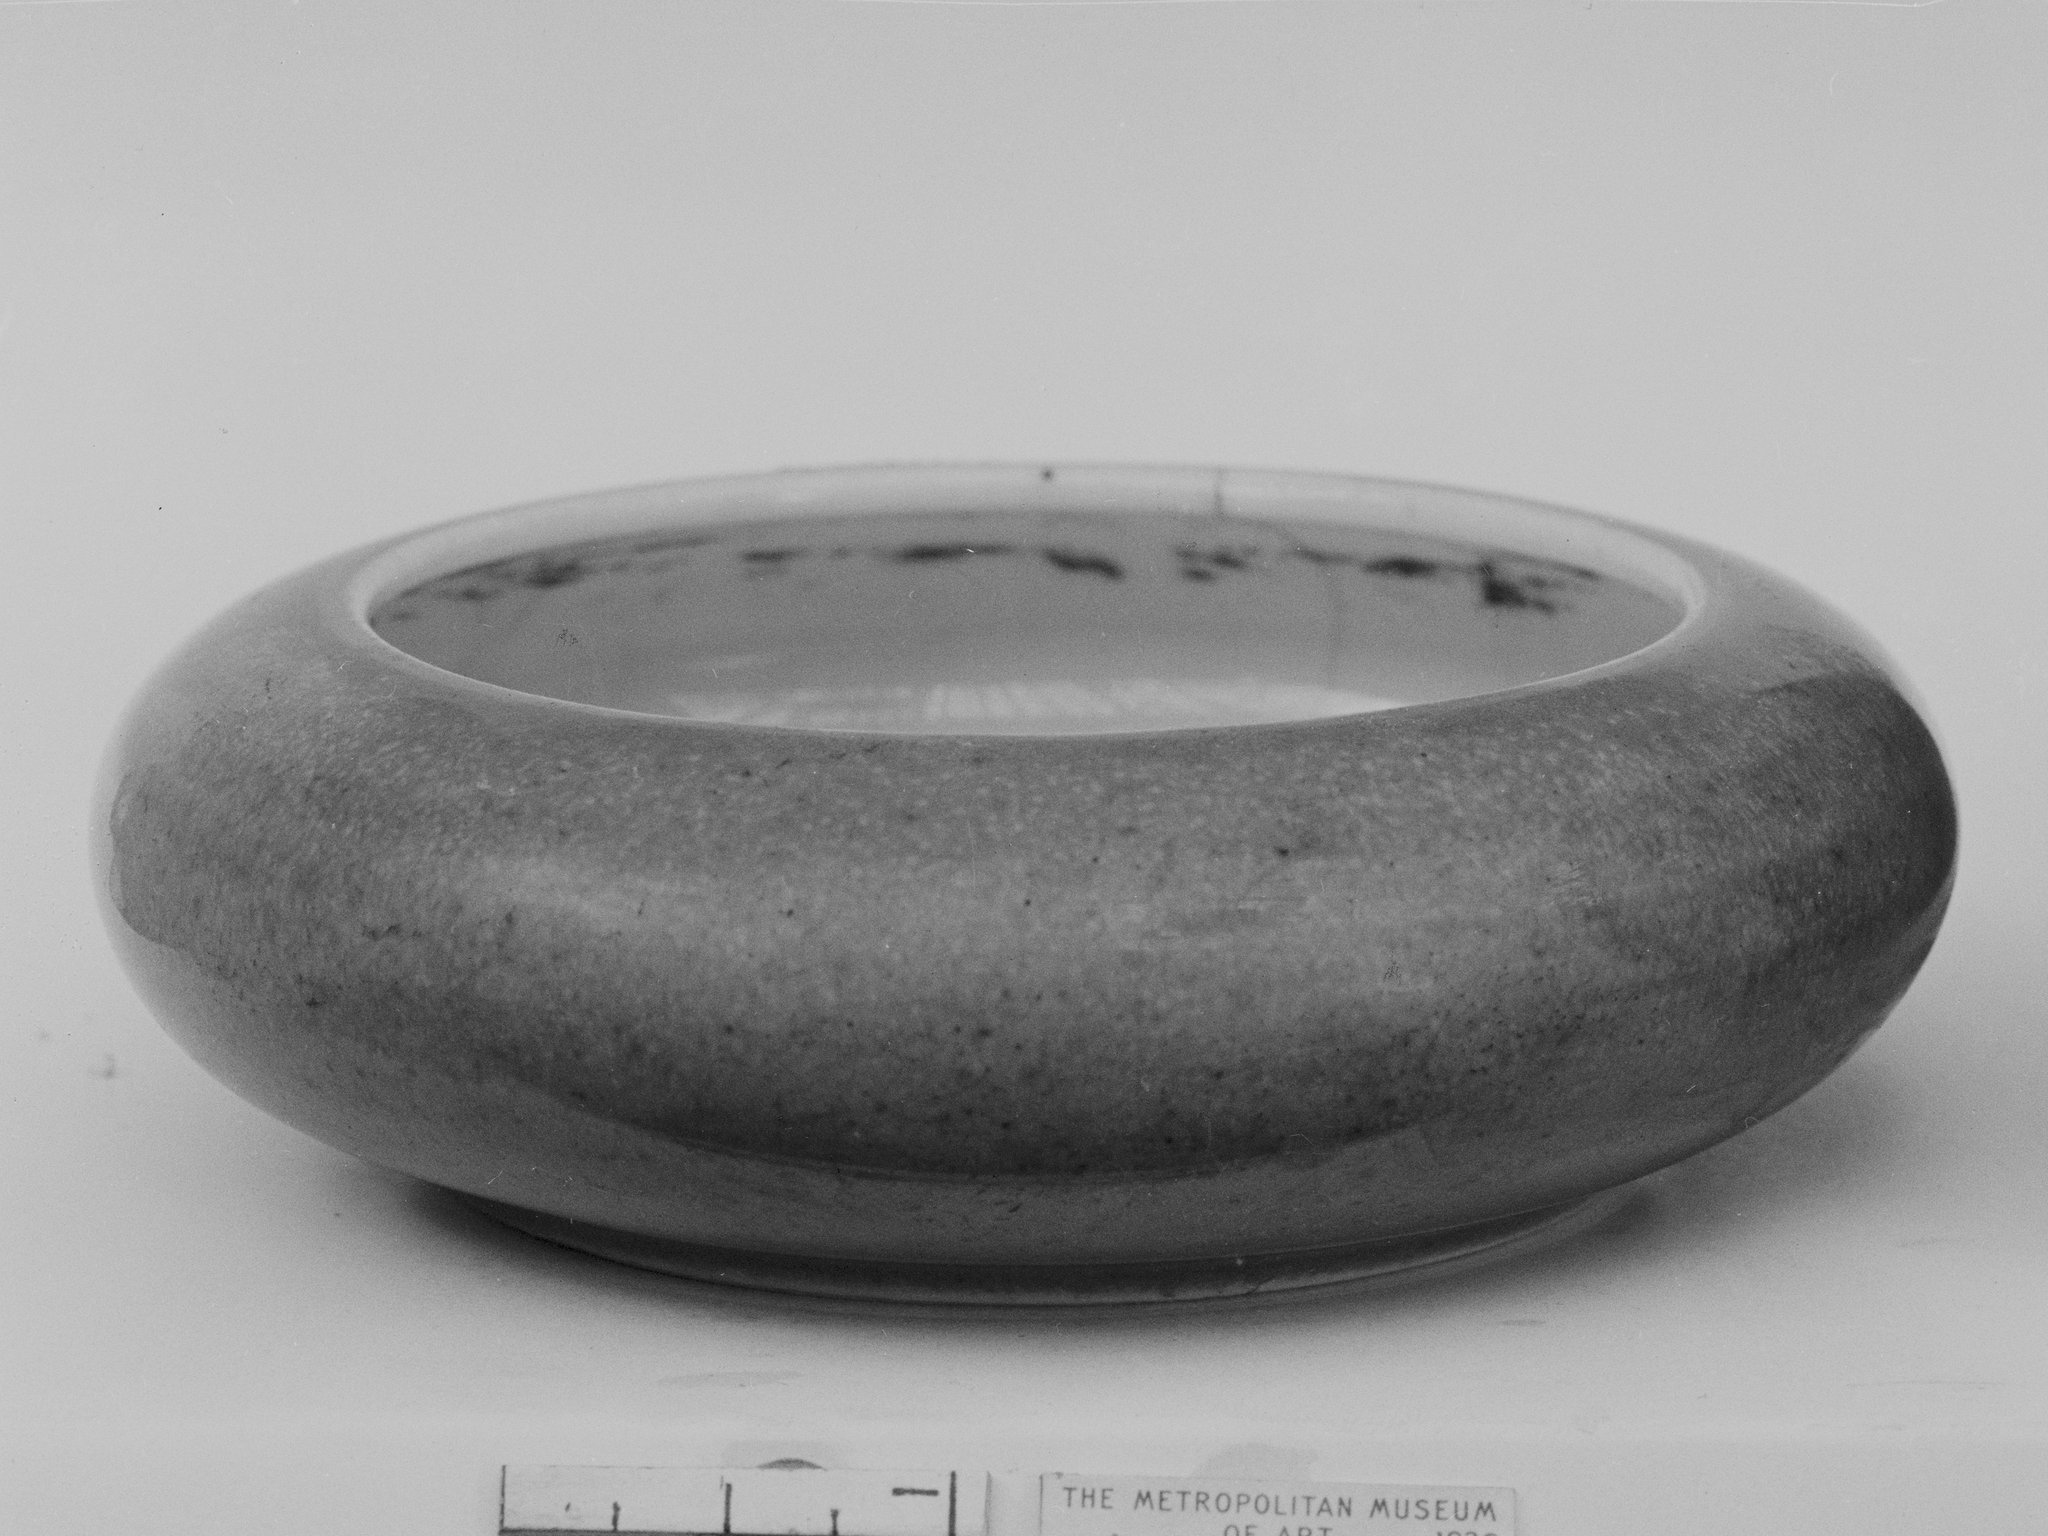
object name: brush washer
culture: chinese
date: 1700-1722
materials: glaze, porcelain